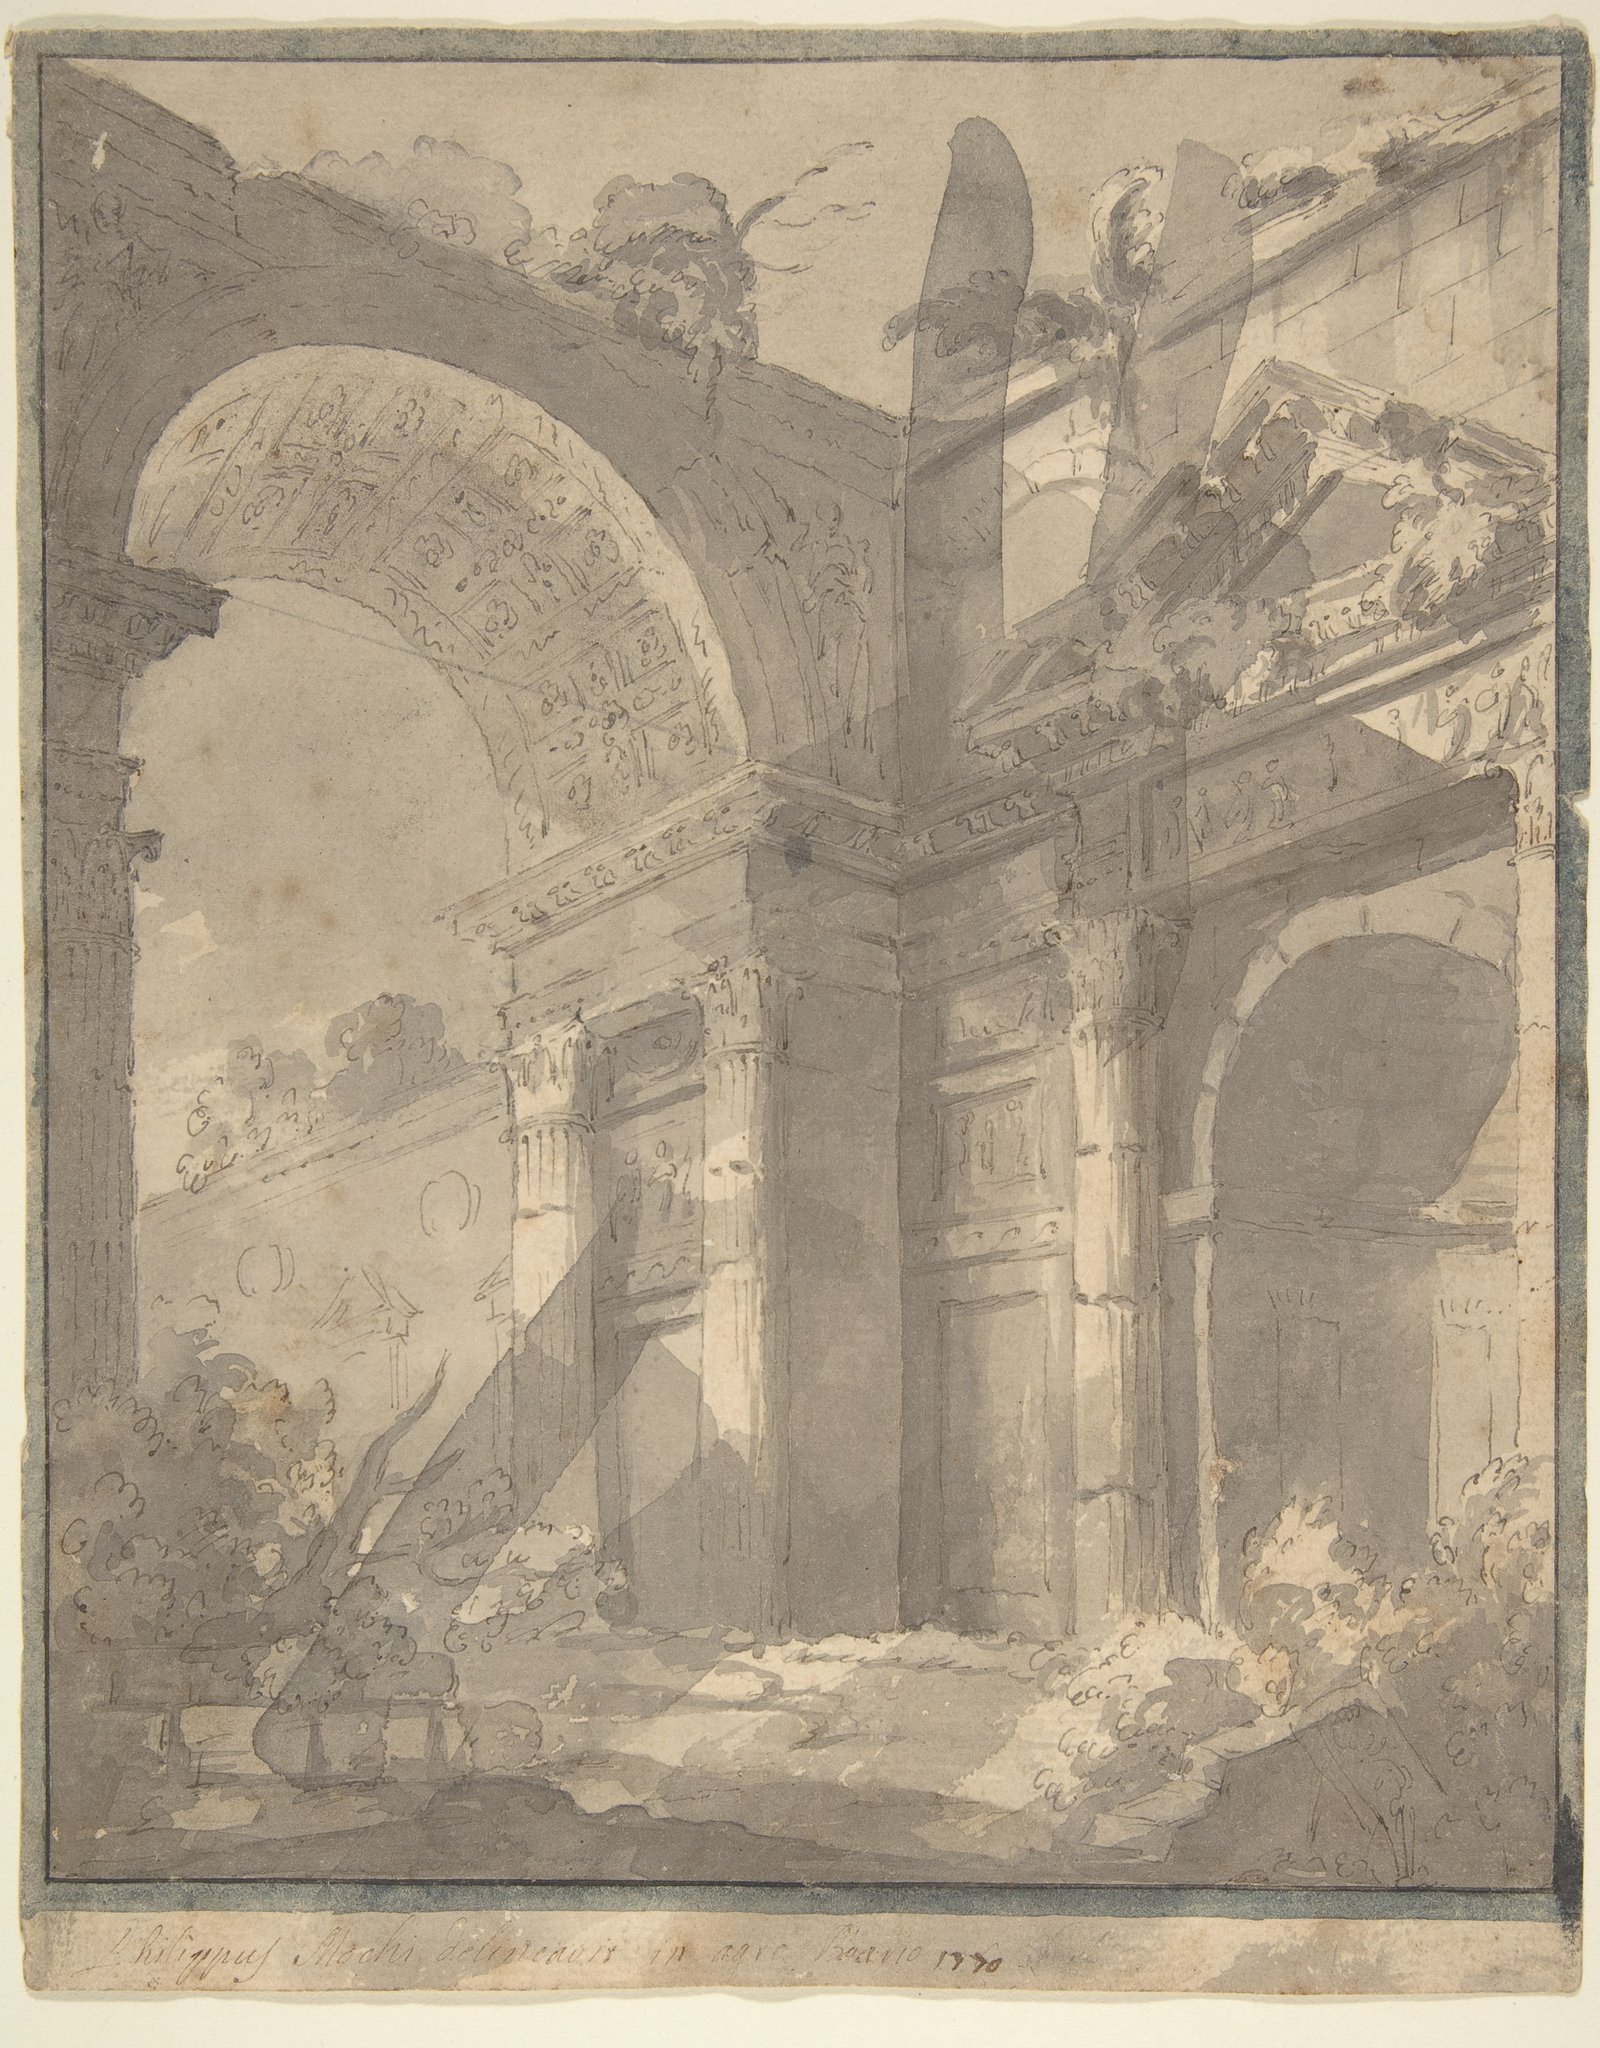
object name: drawing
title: View of Ancient Roman Ruins, an Arch and a Triangular-Pedimented Doorway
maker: filippo mochi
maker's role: artist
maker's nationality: italian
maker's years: 1700-1800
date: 1701-1800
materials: ink, drawing material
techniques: brush, pen, wash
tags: arches,ruins